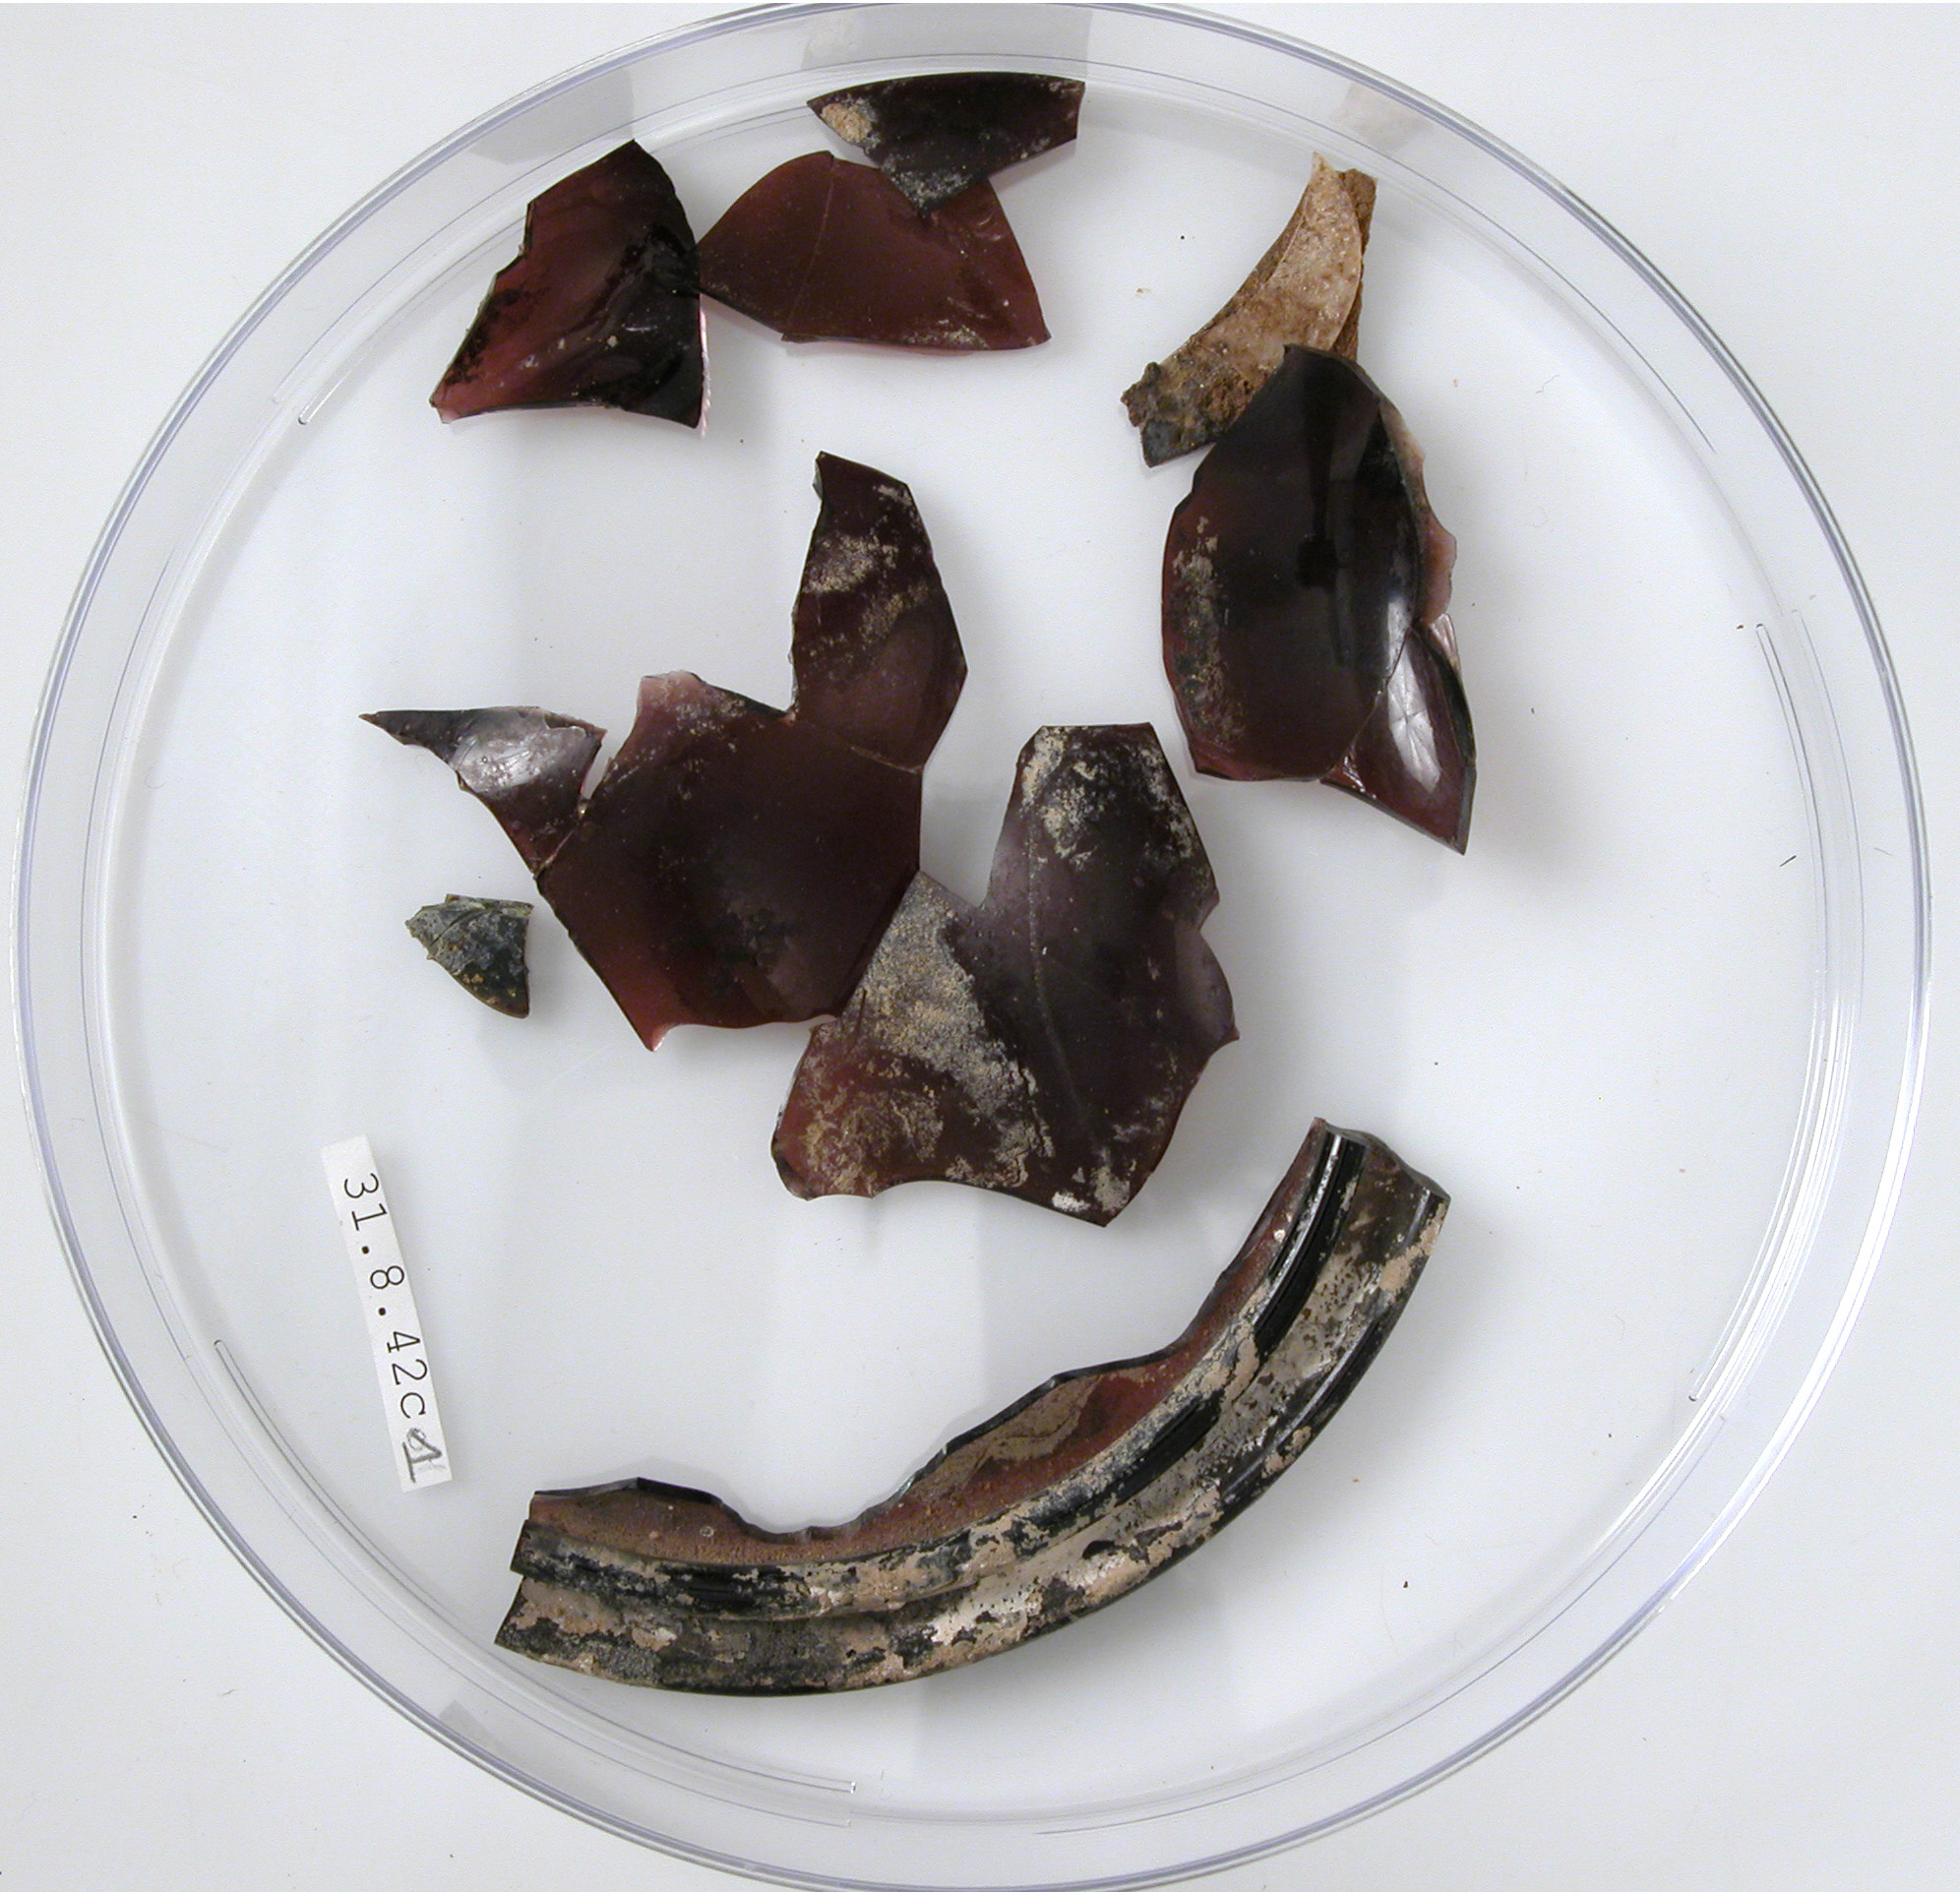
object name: fragment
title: Glass Fragments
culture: coptic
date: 301-400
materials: glass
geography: egypt